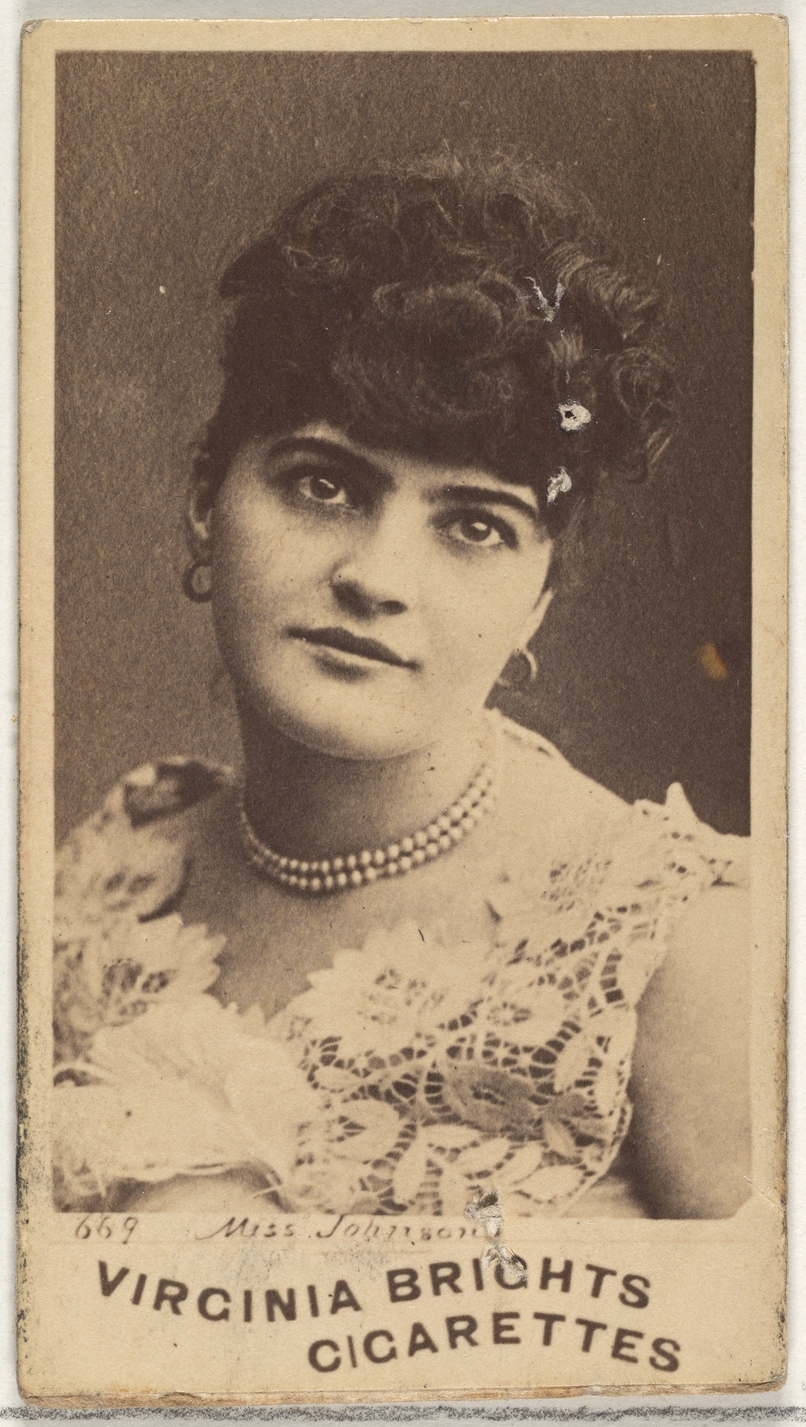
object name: photograph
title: Card 669, Miss Johnson, from the Actors and Actresses series (N45, Type 1) for Virginia Brights Cigarettes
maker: allen & ginter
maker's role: publisher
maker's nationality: american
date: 1888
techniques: albumen silver print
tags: portraits,women,actresses